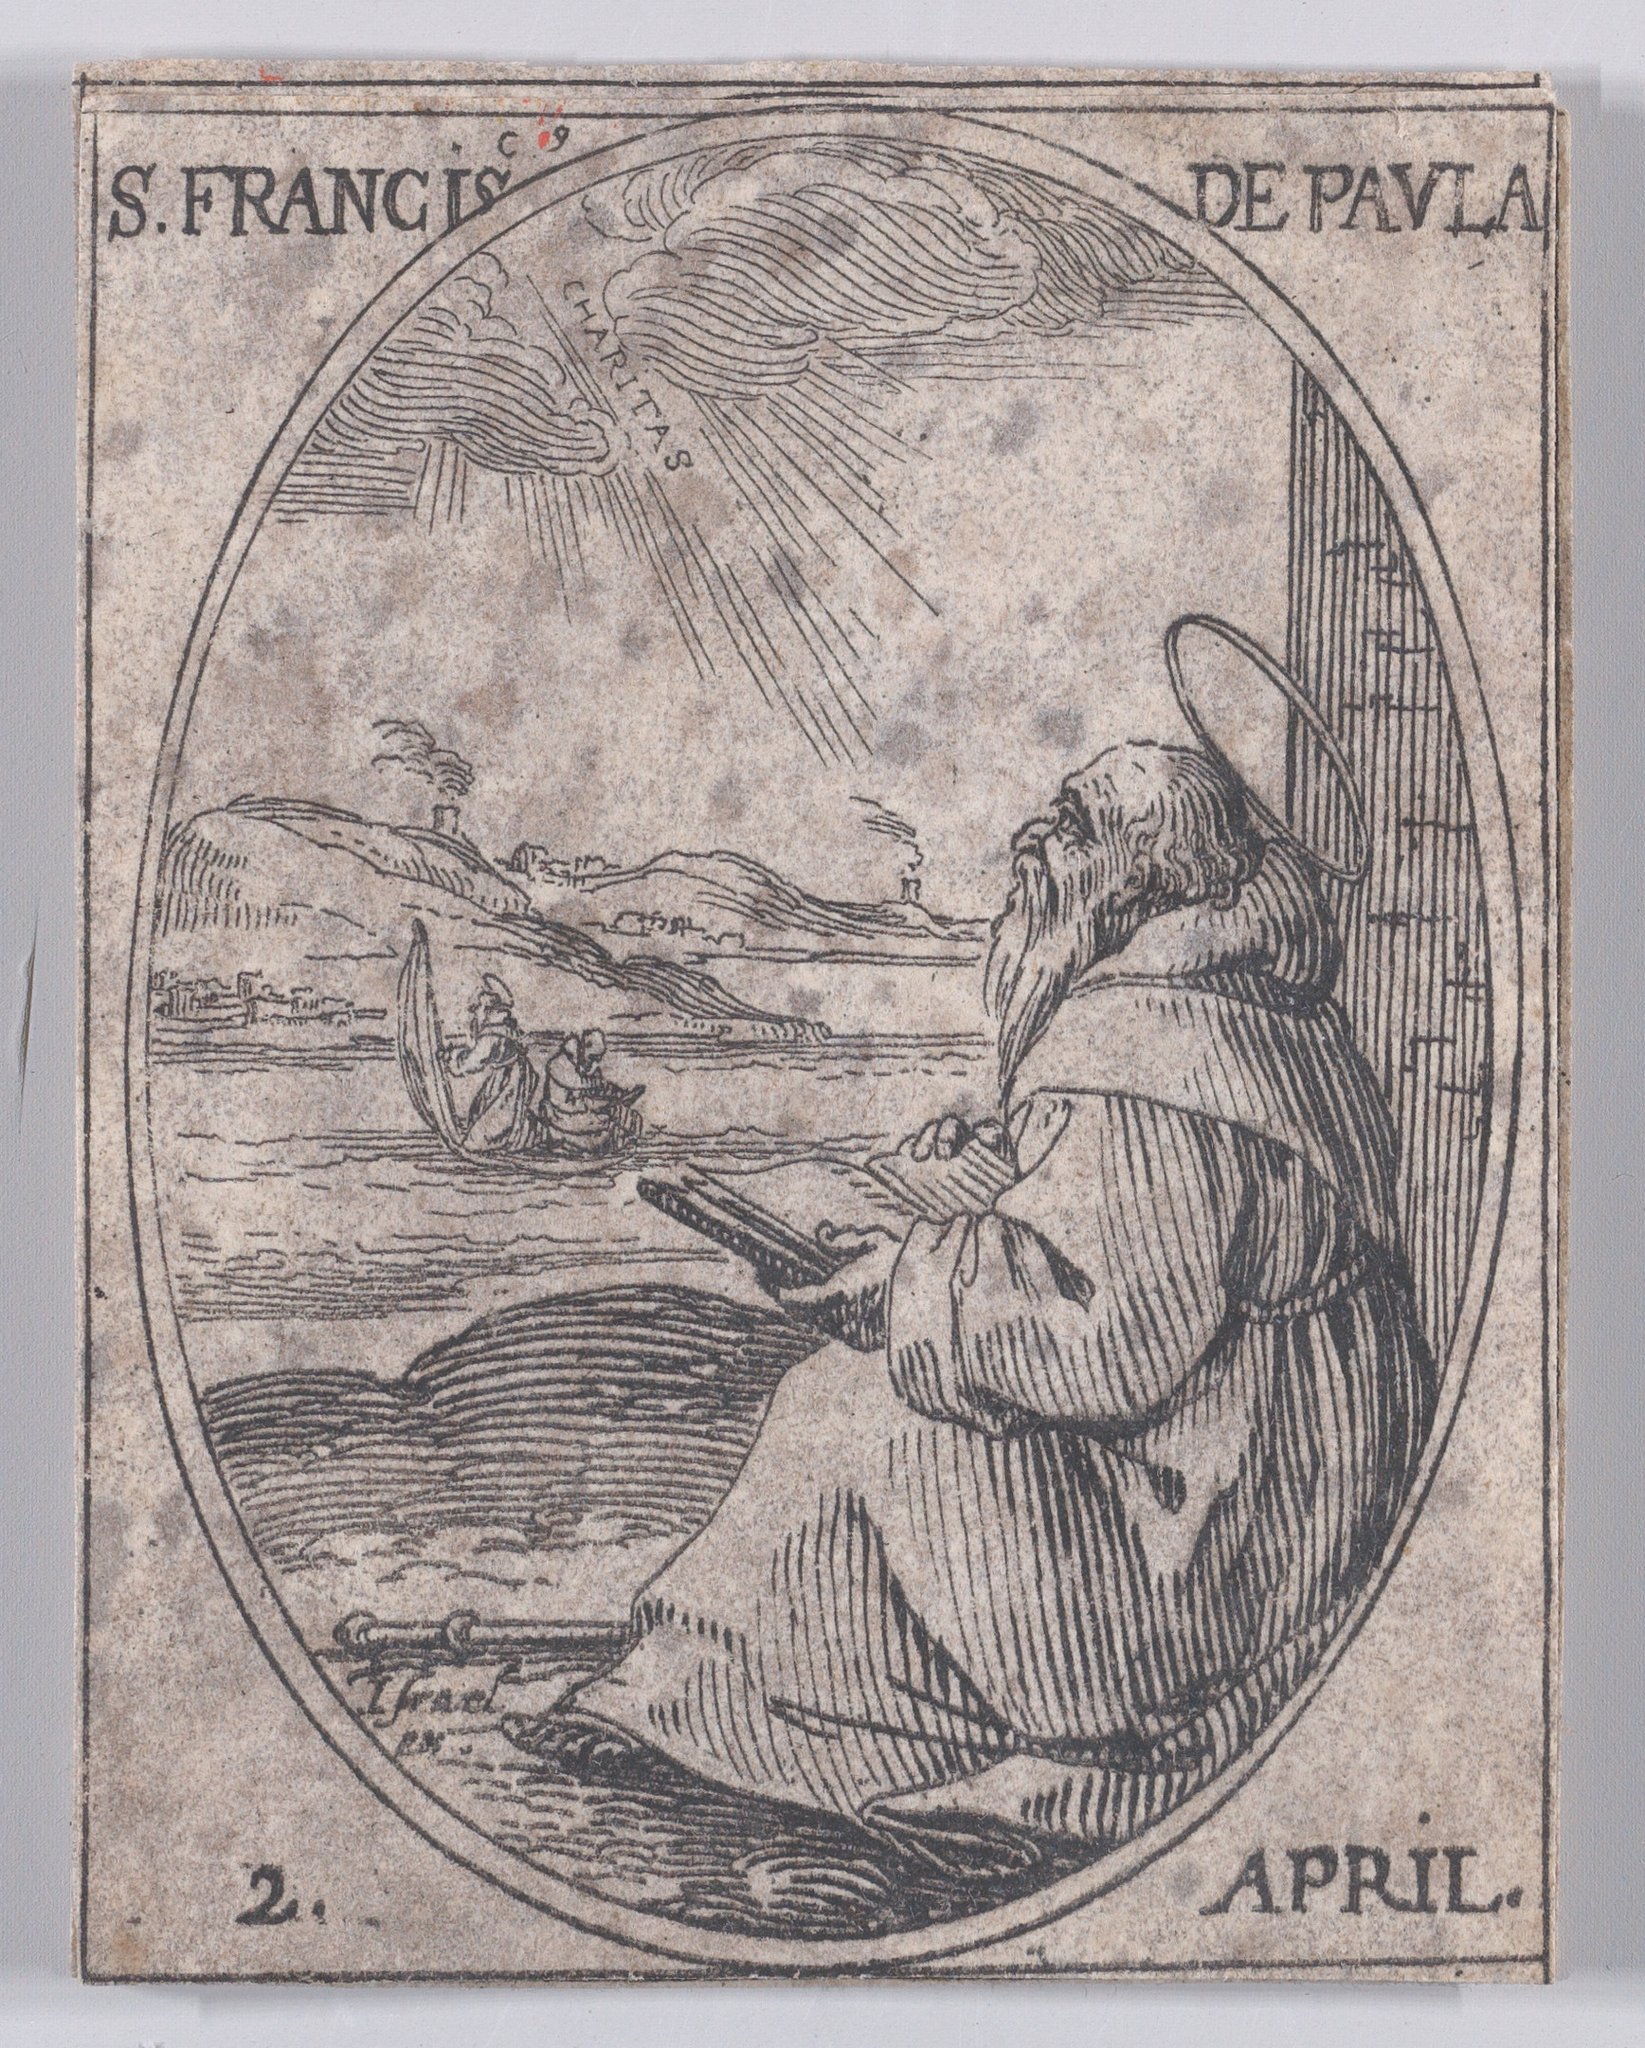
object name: print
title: S. François de Paule (St. Francis of Paola), April 2nd, from "Les Images De Tous Les Saincts et Saintes de L'Année" (Images of All of the Saints and Religious Events of the Year)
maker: jacques callot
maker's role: artist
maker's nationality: french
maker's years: 1592-1635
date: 1636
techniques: etching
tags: men,saints